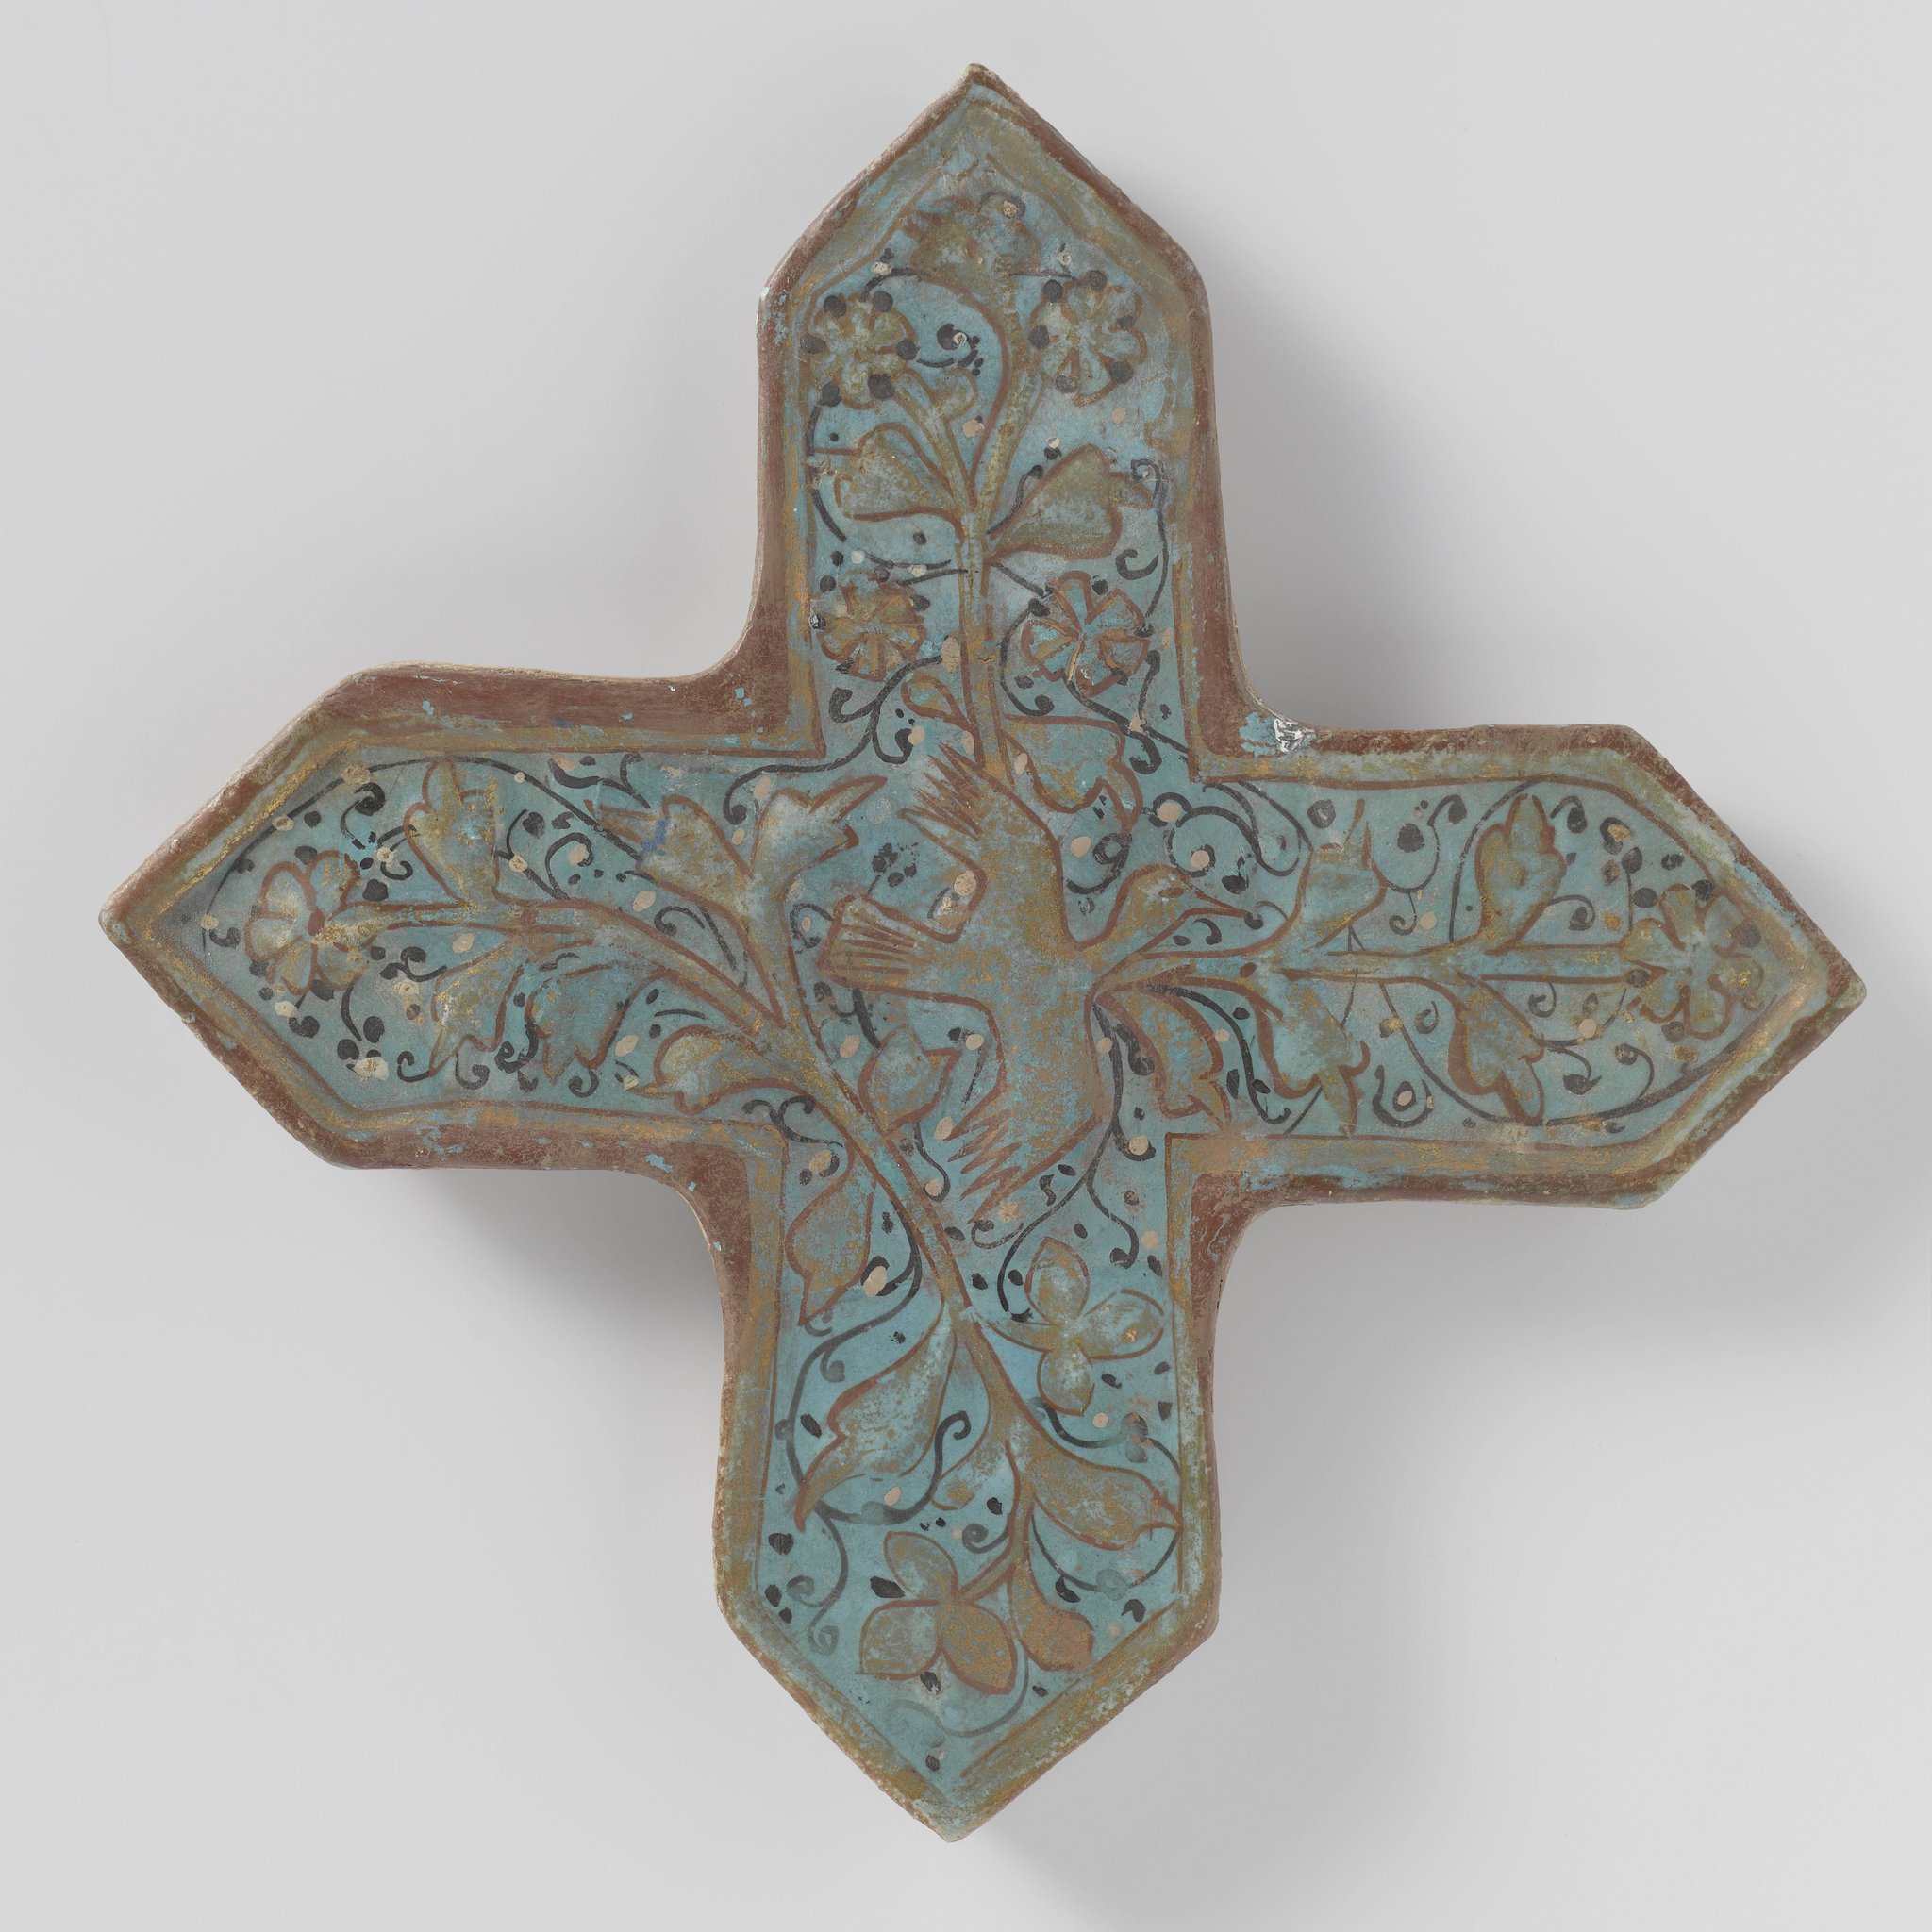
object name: kruistegel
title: Tile in the shape of a cross with a bird among floral scrolls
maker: Anonymous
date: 1250-1299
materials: earthenware, glaze, gold, paint, quartz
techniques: forming, gilding, turning, vitrification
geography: iran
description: Tegel van kwarts-fritgoed met op turquoise fond een vogel tussen bloemranken.